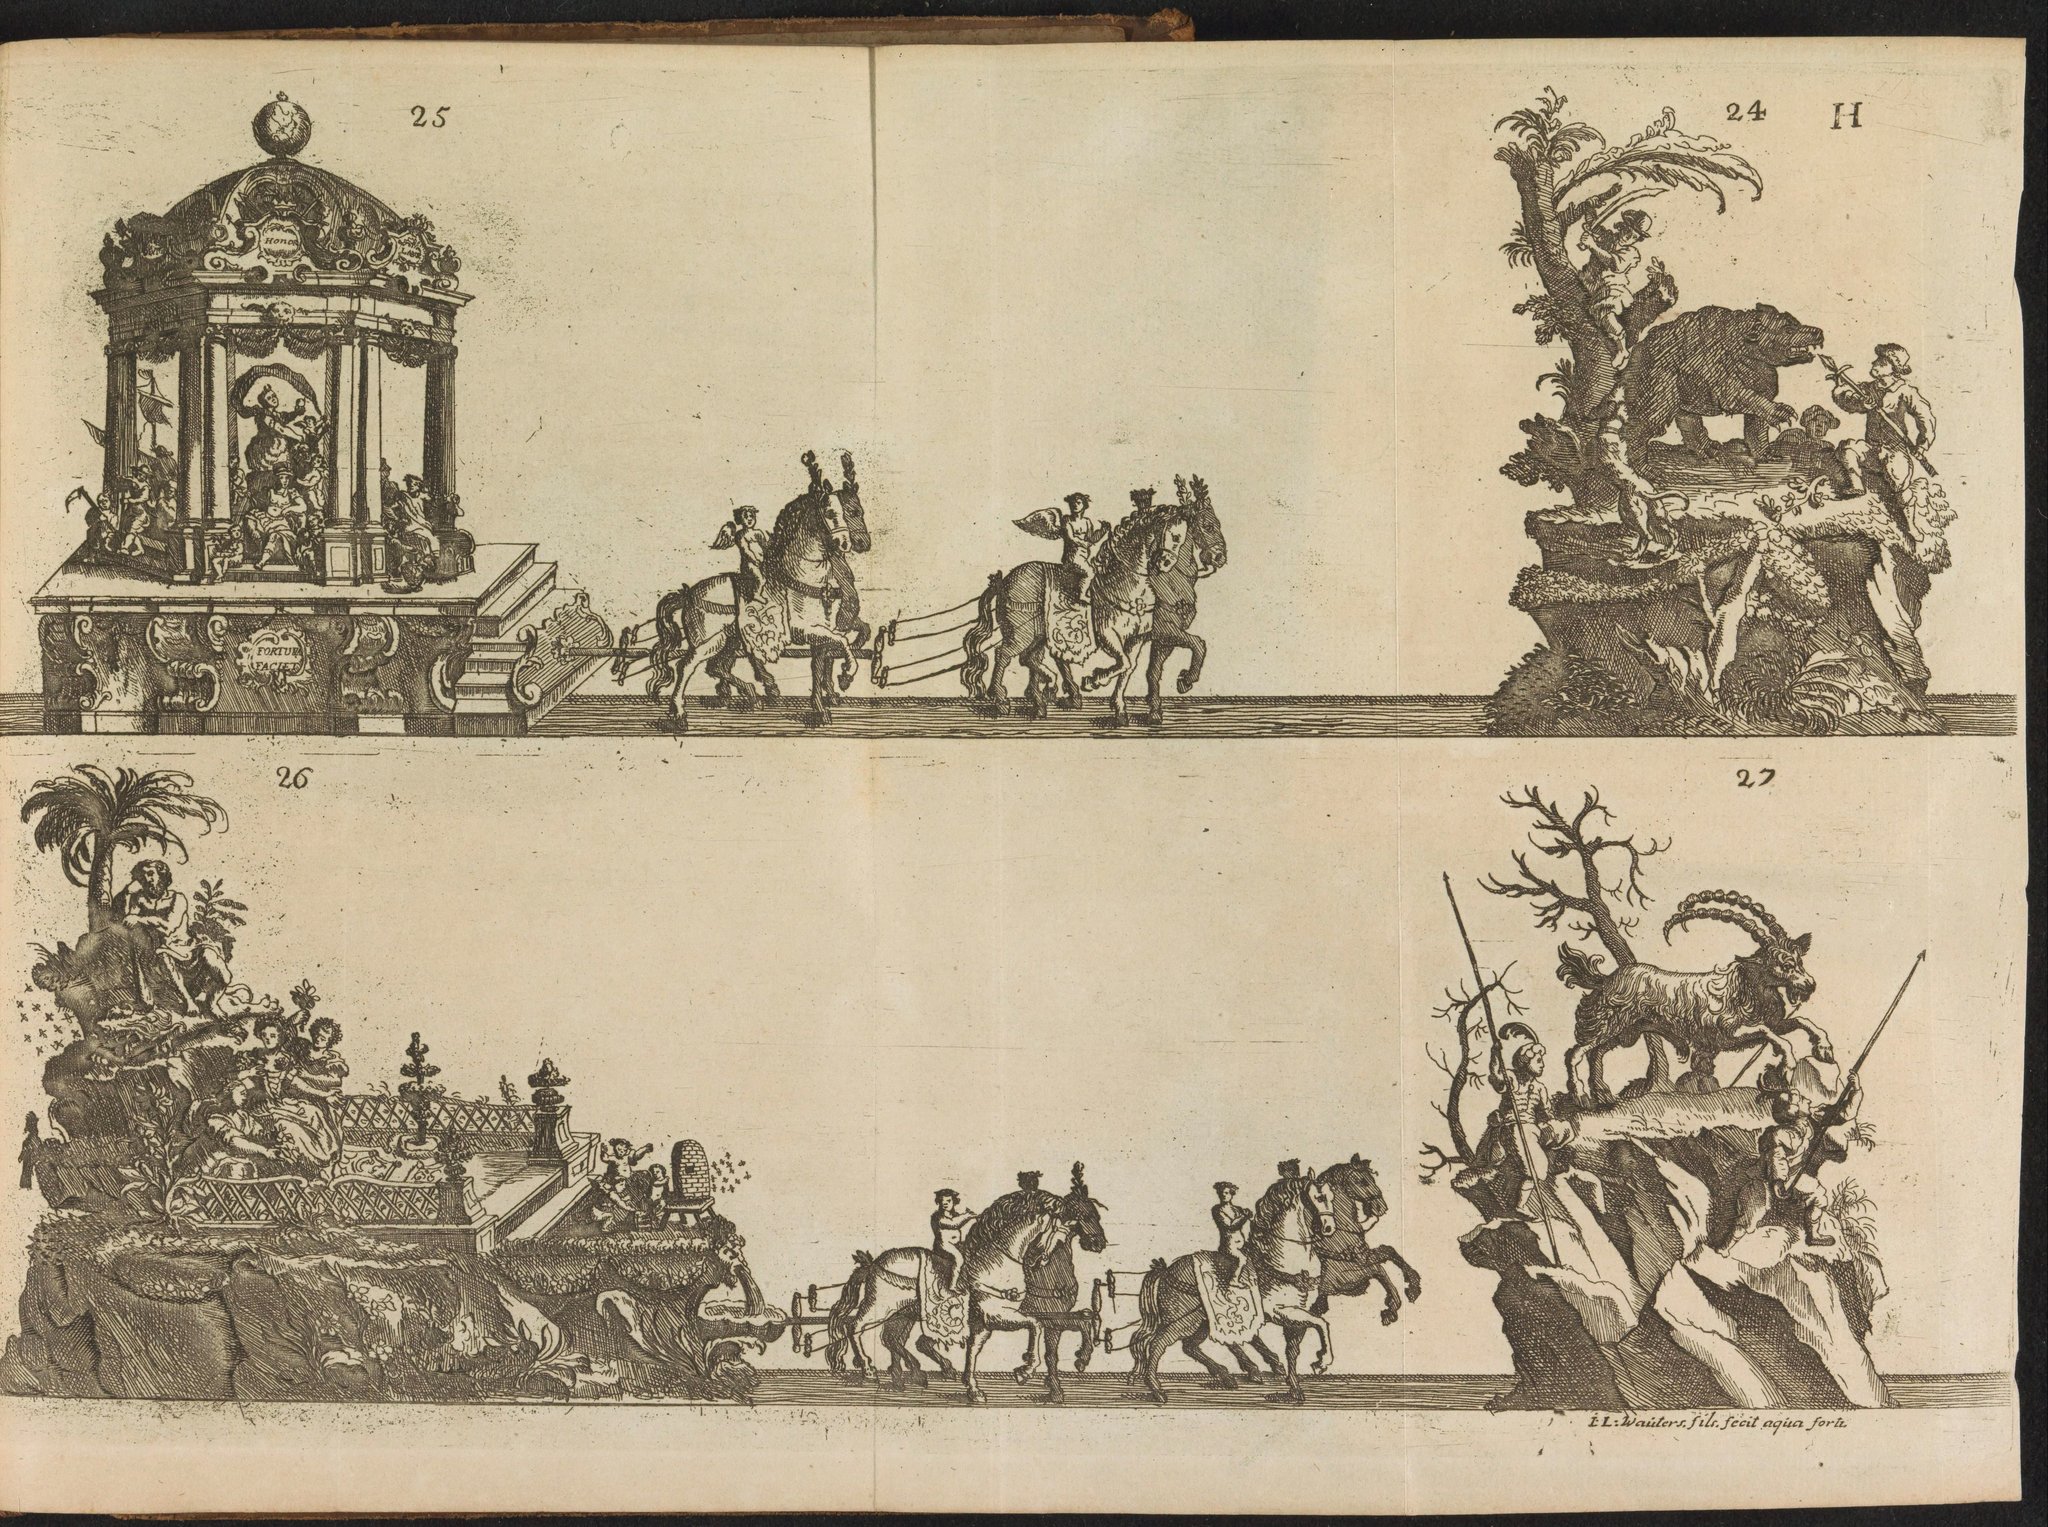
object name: print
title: Blad H: twaalfde en dertiende praalwagen, 1767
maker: lieven wouters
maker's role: print maker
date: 1767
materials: paper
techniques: engraving, etching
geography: ghent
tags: spring, 'ver'; 'primavera' (ripa), male saints (macarius of antioch), hoofed animals: ibex, chariot, triumphal car, luck, fortune, lot; 'fato', 'fortuna', 'fortuna aurea', 'fortuna buona', 'fortuna pacifica overo clemente', 'sorte' (ripa), ghent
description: Blad H met de twaalfde en dertiende praalwagen en het twaalfde en dertiende dier. Twaalfde triomfwagen met de allegorische verbeelding van Fortuna. Twaalfde dier: beer. Dertiende praalwagen met de allegorische verbeelding van het seizoen Voorjaar (Lente). Dertiende dier: ibex. Gemerkt: H / 24-27. Onderdeel van de optocht bij de viering op 30 mei 1767 van het 700-jarige jubileum van de Heilige Macarius, patroon van de stad Gent en beschermheilige tegen de pest.